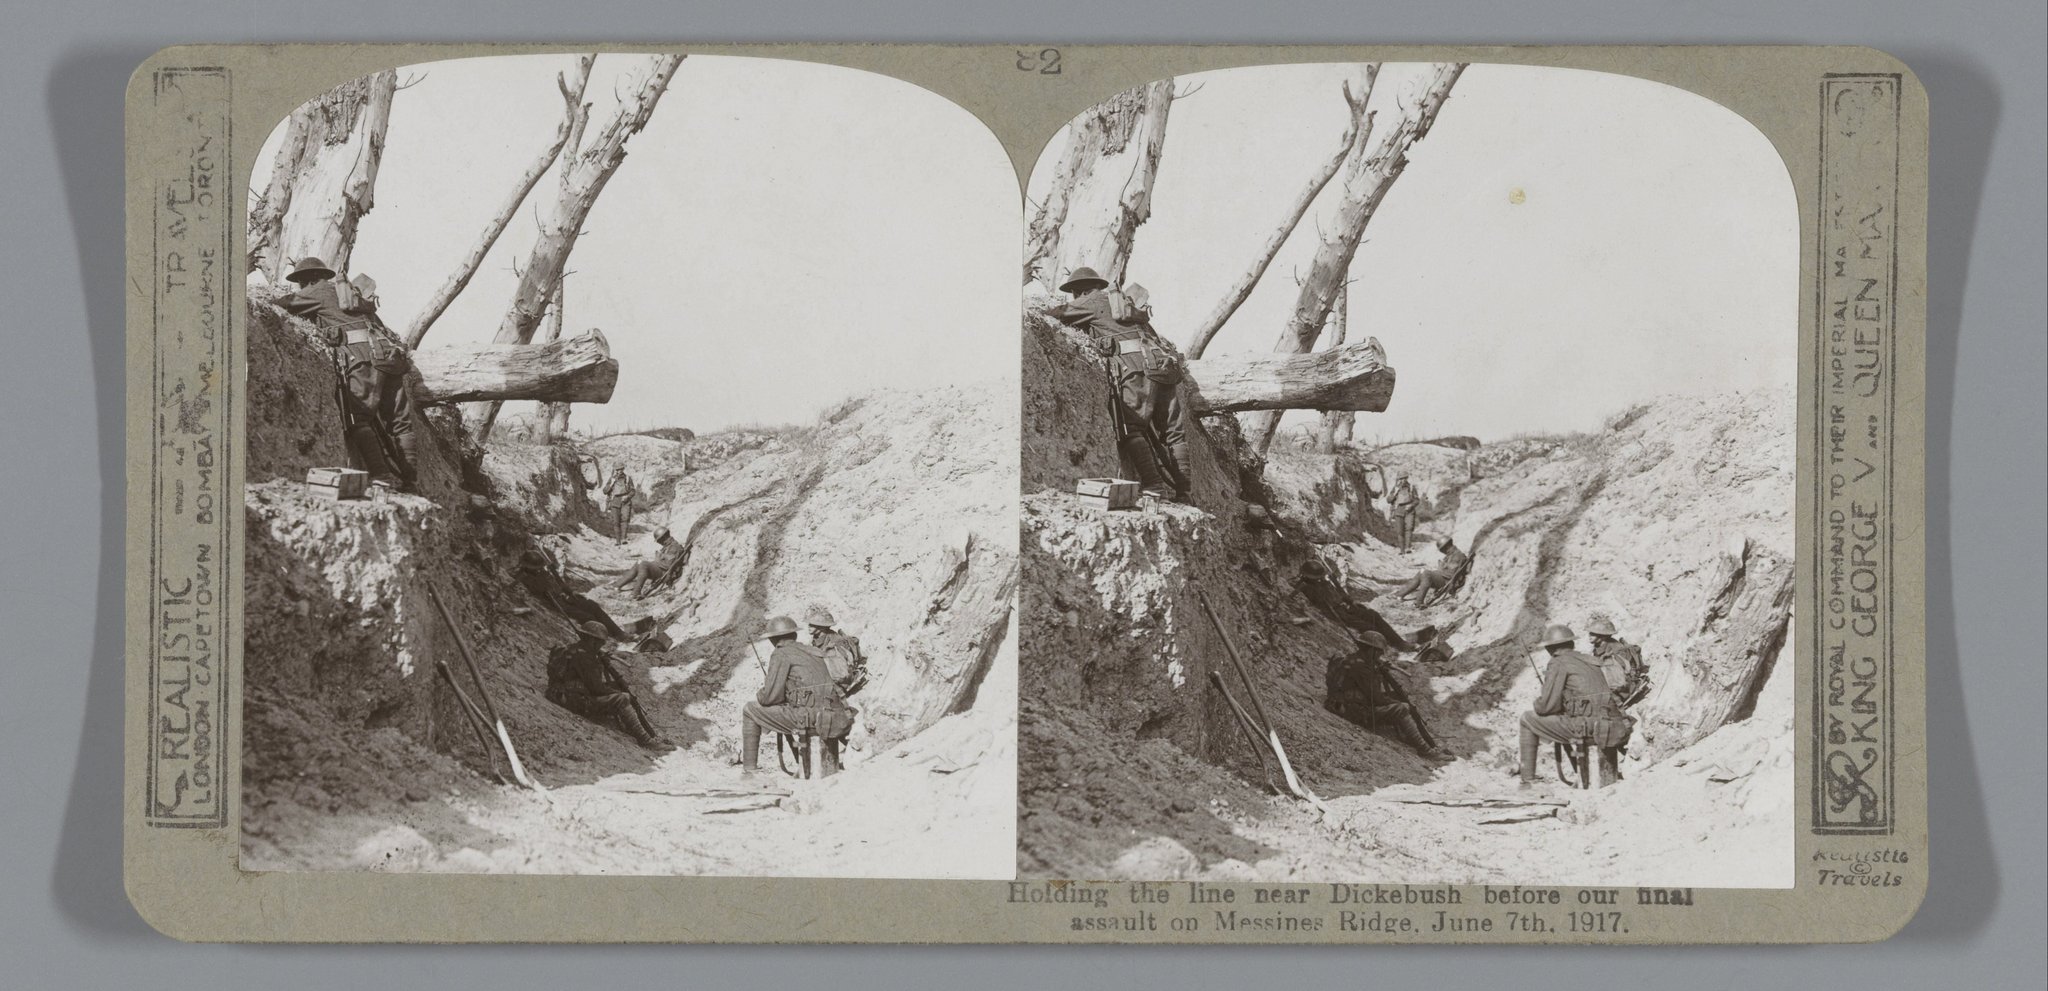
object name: stereograph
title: Holding the line near Dickebush before our final assault on Messines Ridge, June 7th, 1917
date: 1917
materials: cardboard, photographic support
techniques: gelatin silver print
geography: flanders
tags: private soldier, trenches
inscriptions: number: ‘82’, inscription: ‘By Royal command to their Imperial majesties King George V and Queen Mary’